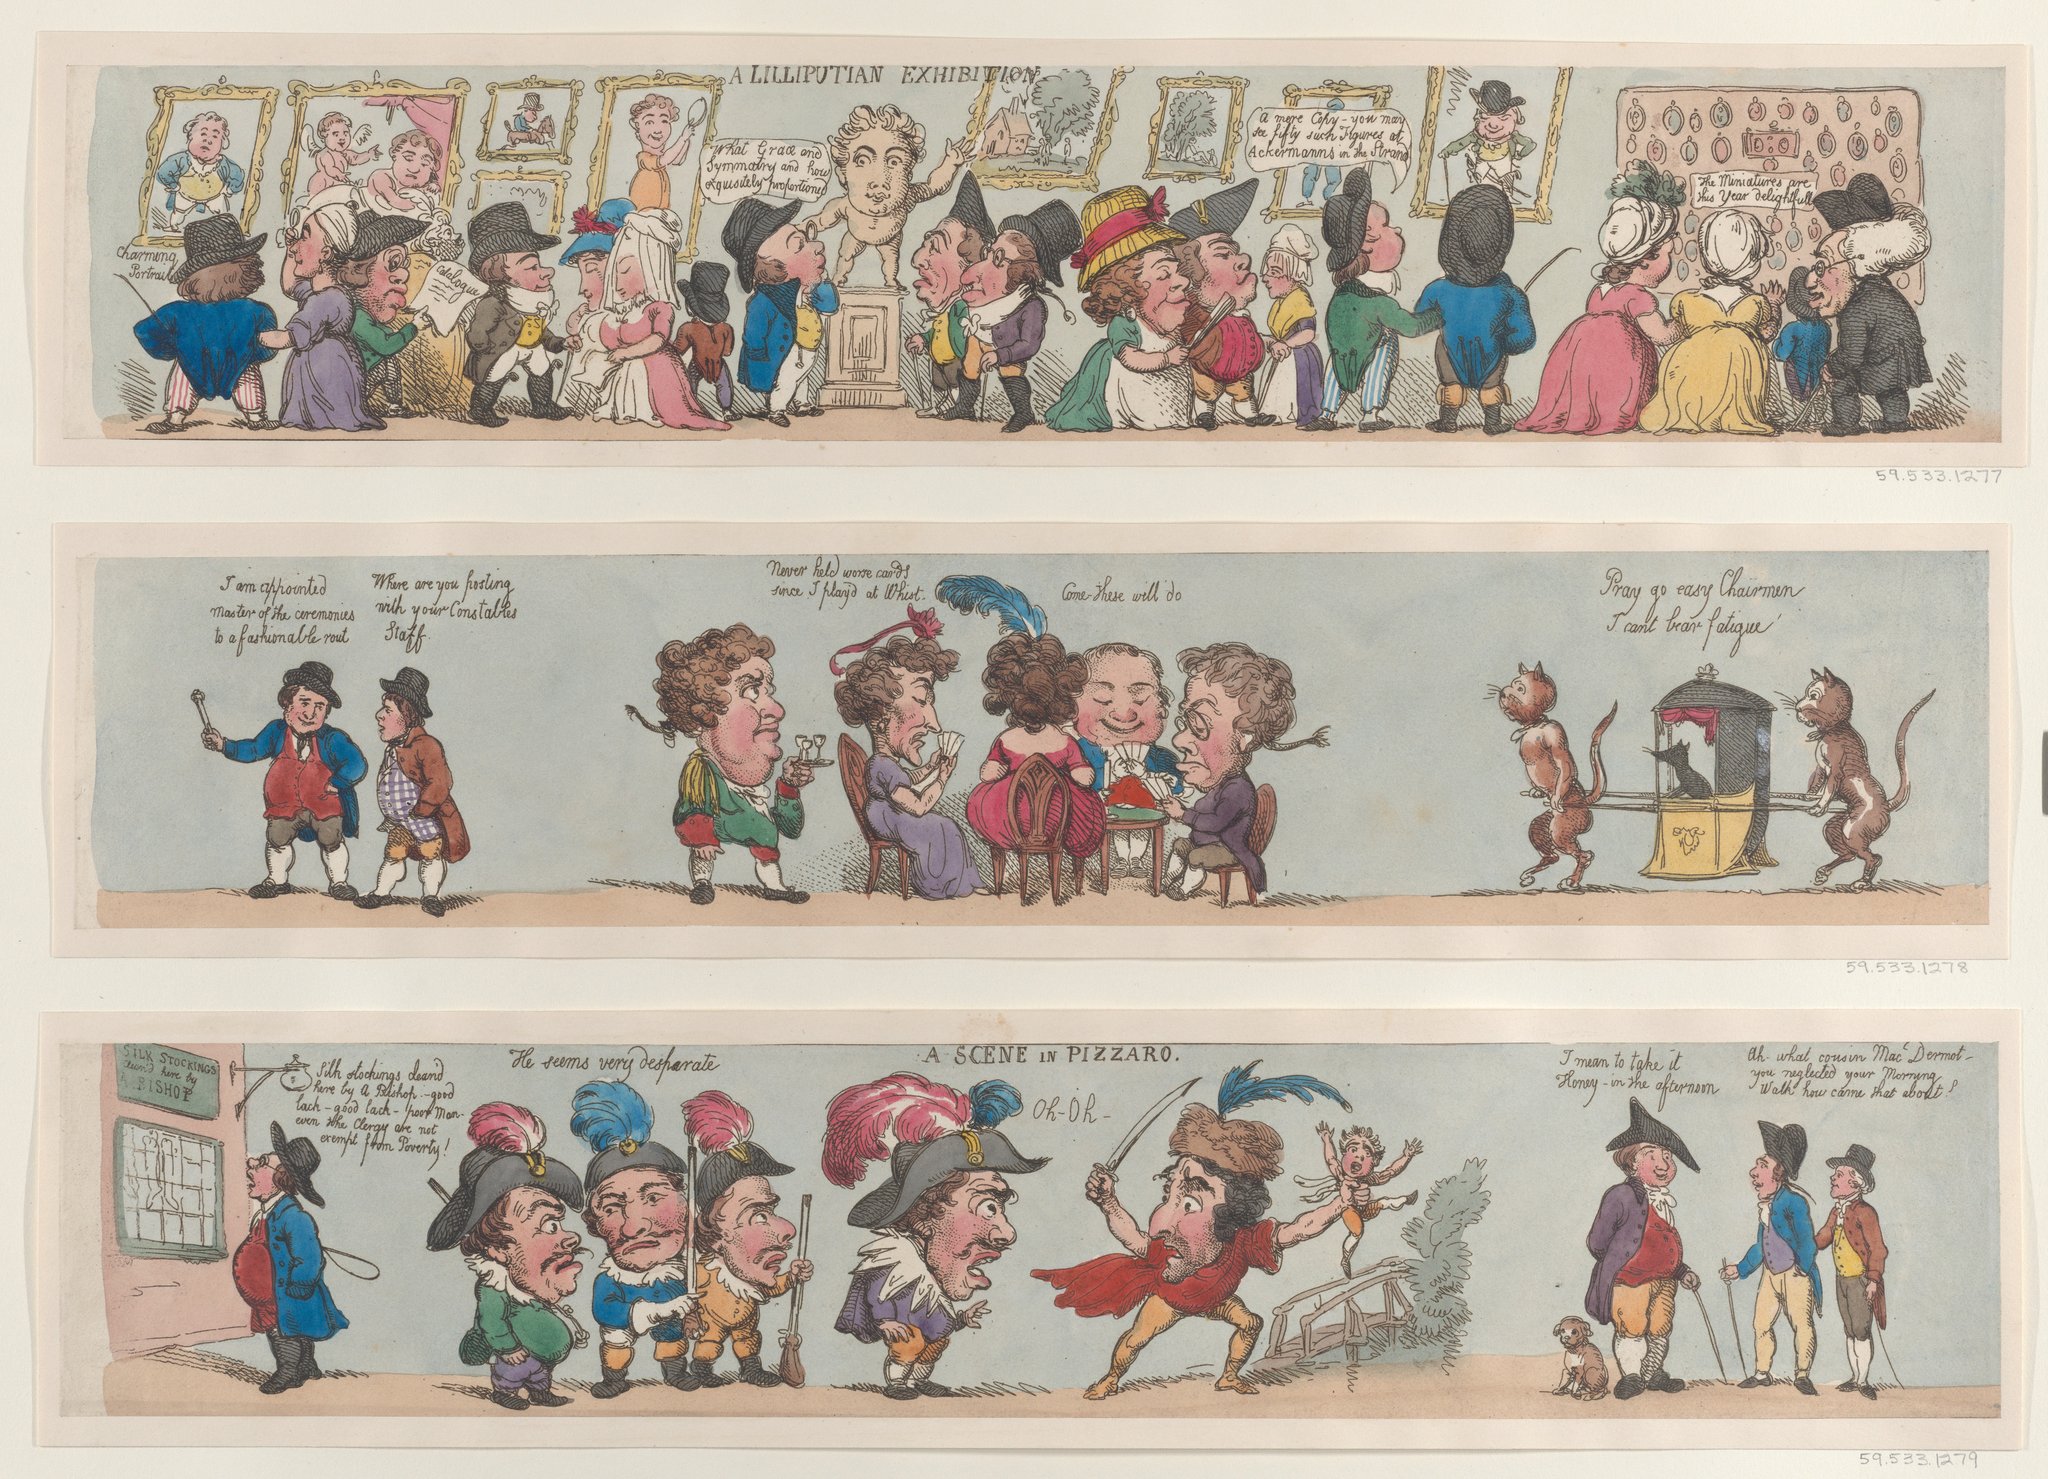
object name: print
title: A Scene in Pizzaro, Grotesque Borders for Rooms & Halls (?)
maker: thomas rowlandson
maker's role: artist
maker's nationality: british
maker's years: 1757-1827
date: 1799-1800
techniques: etching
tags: satire,men,women,cats